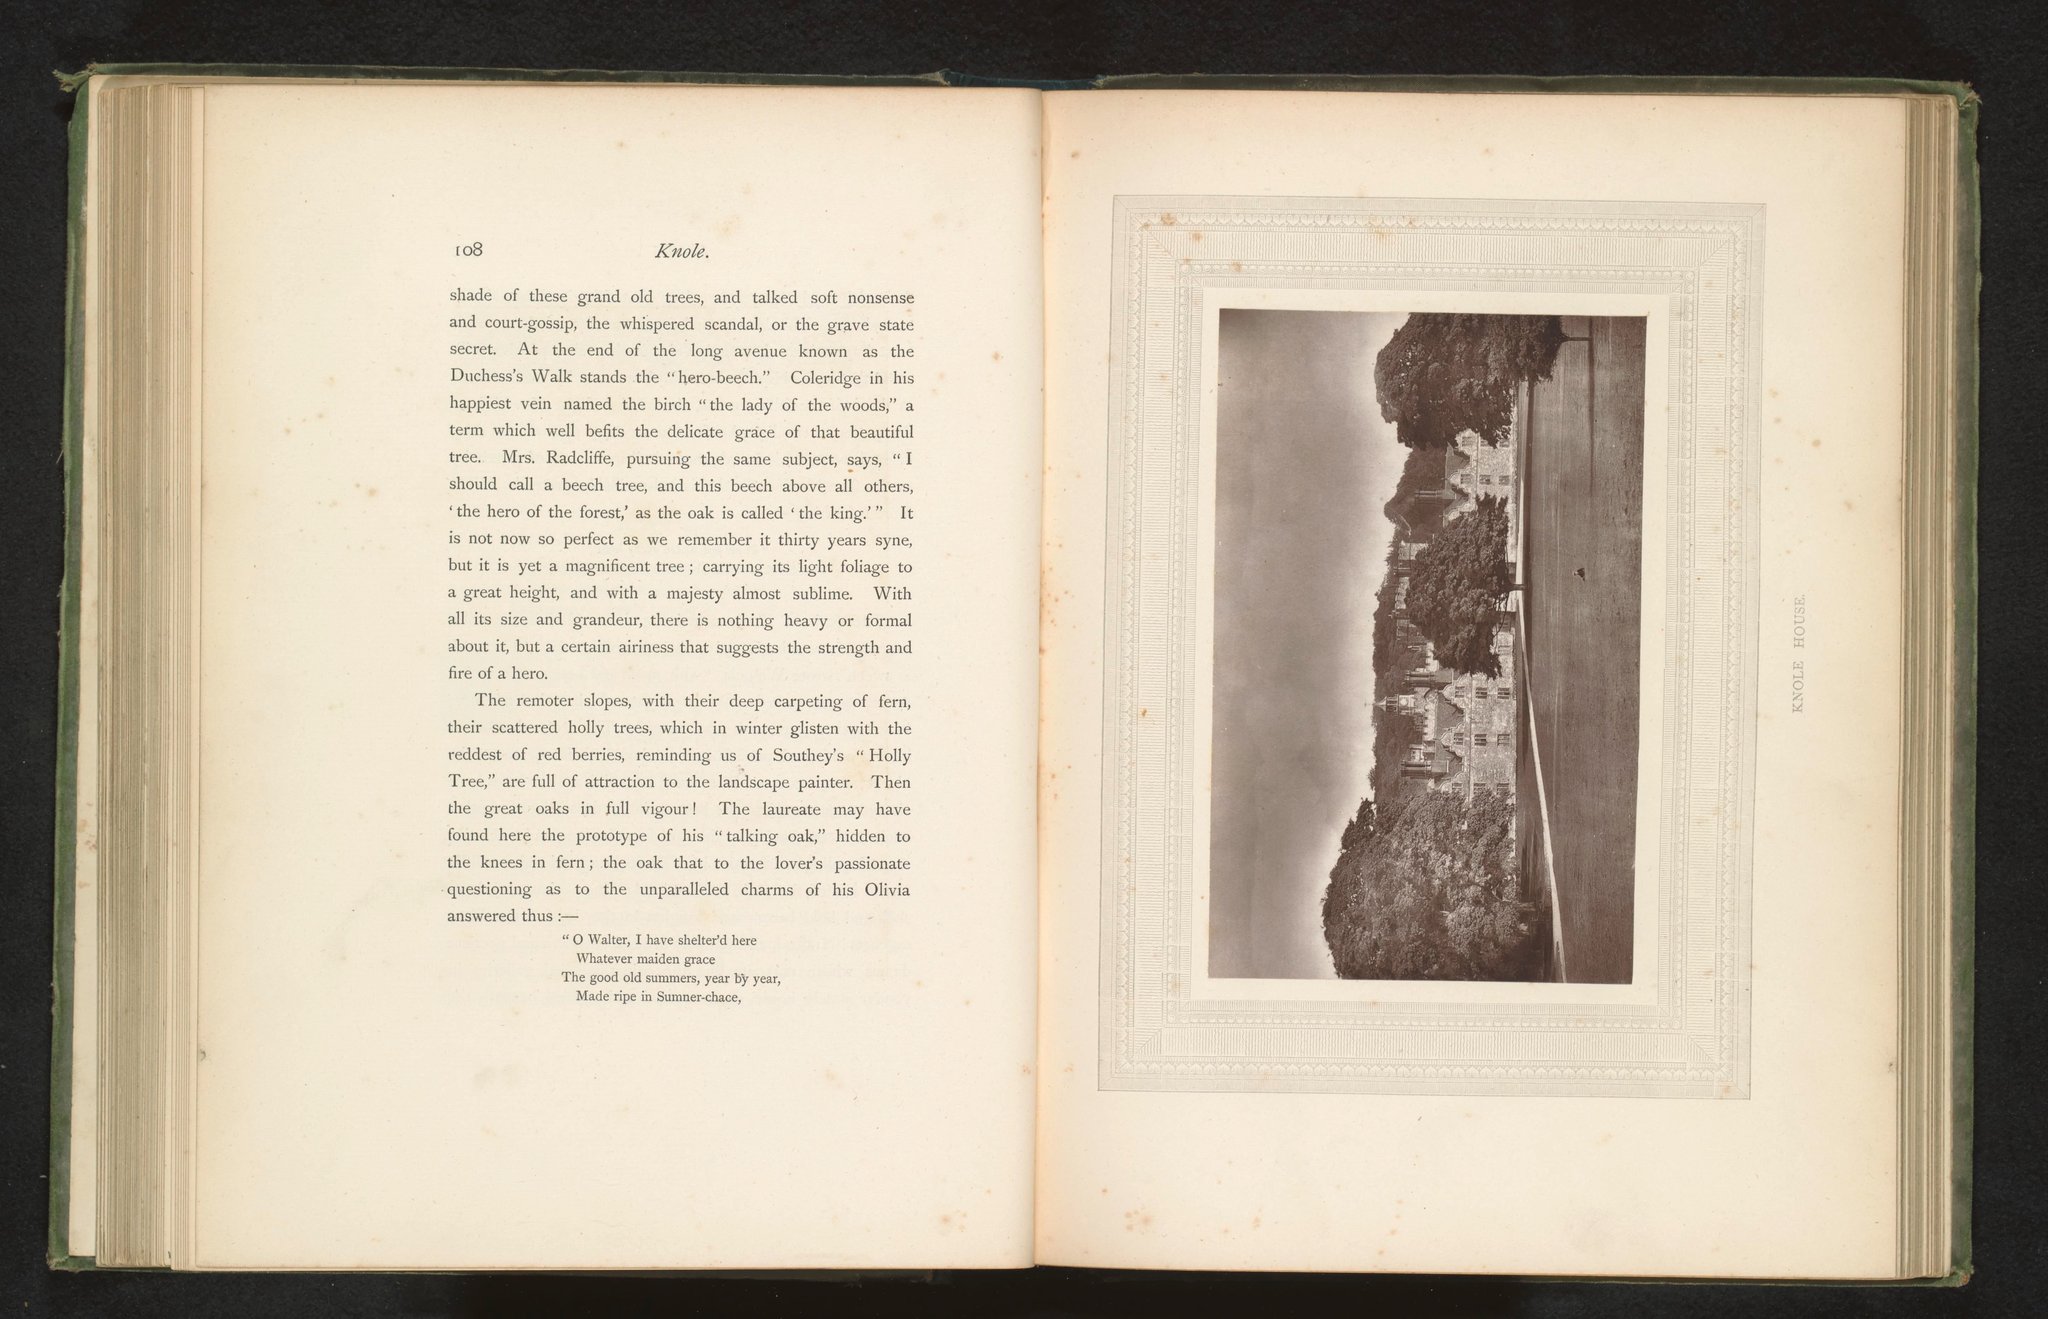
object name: page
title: Knole House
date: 1866-1876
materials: paper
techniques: woodburytype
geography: kent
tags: country-house